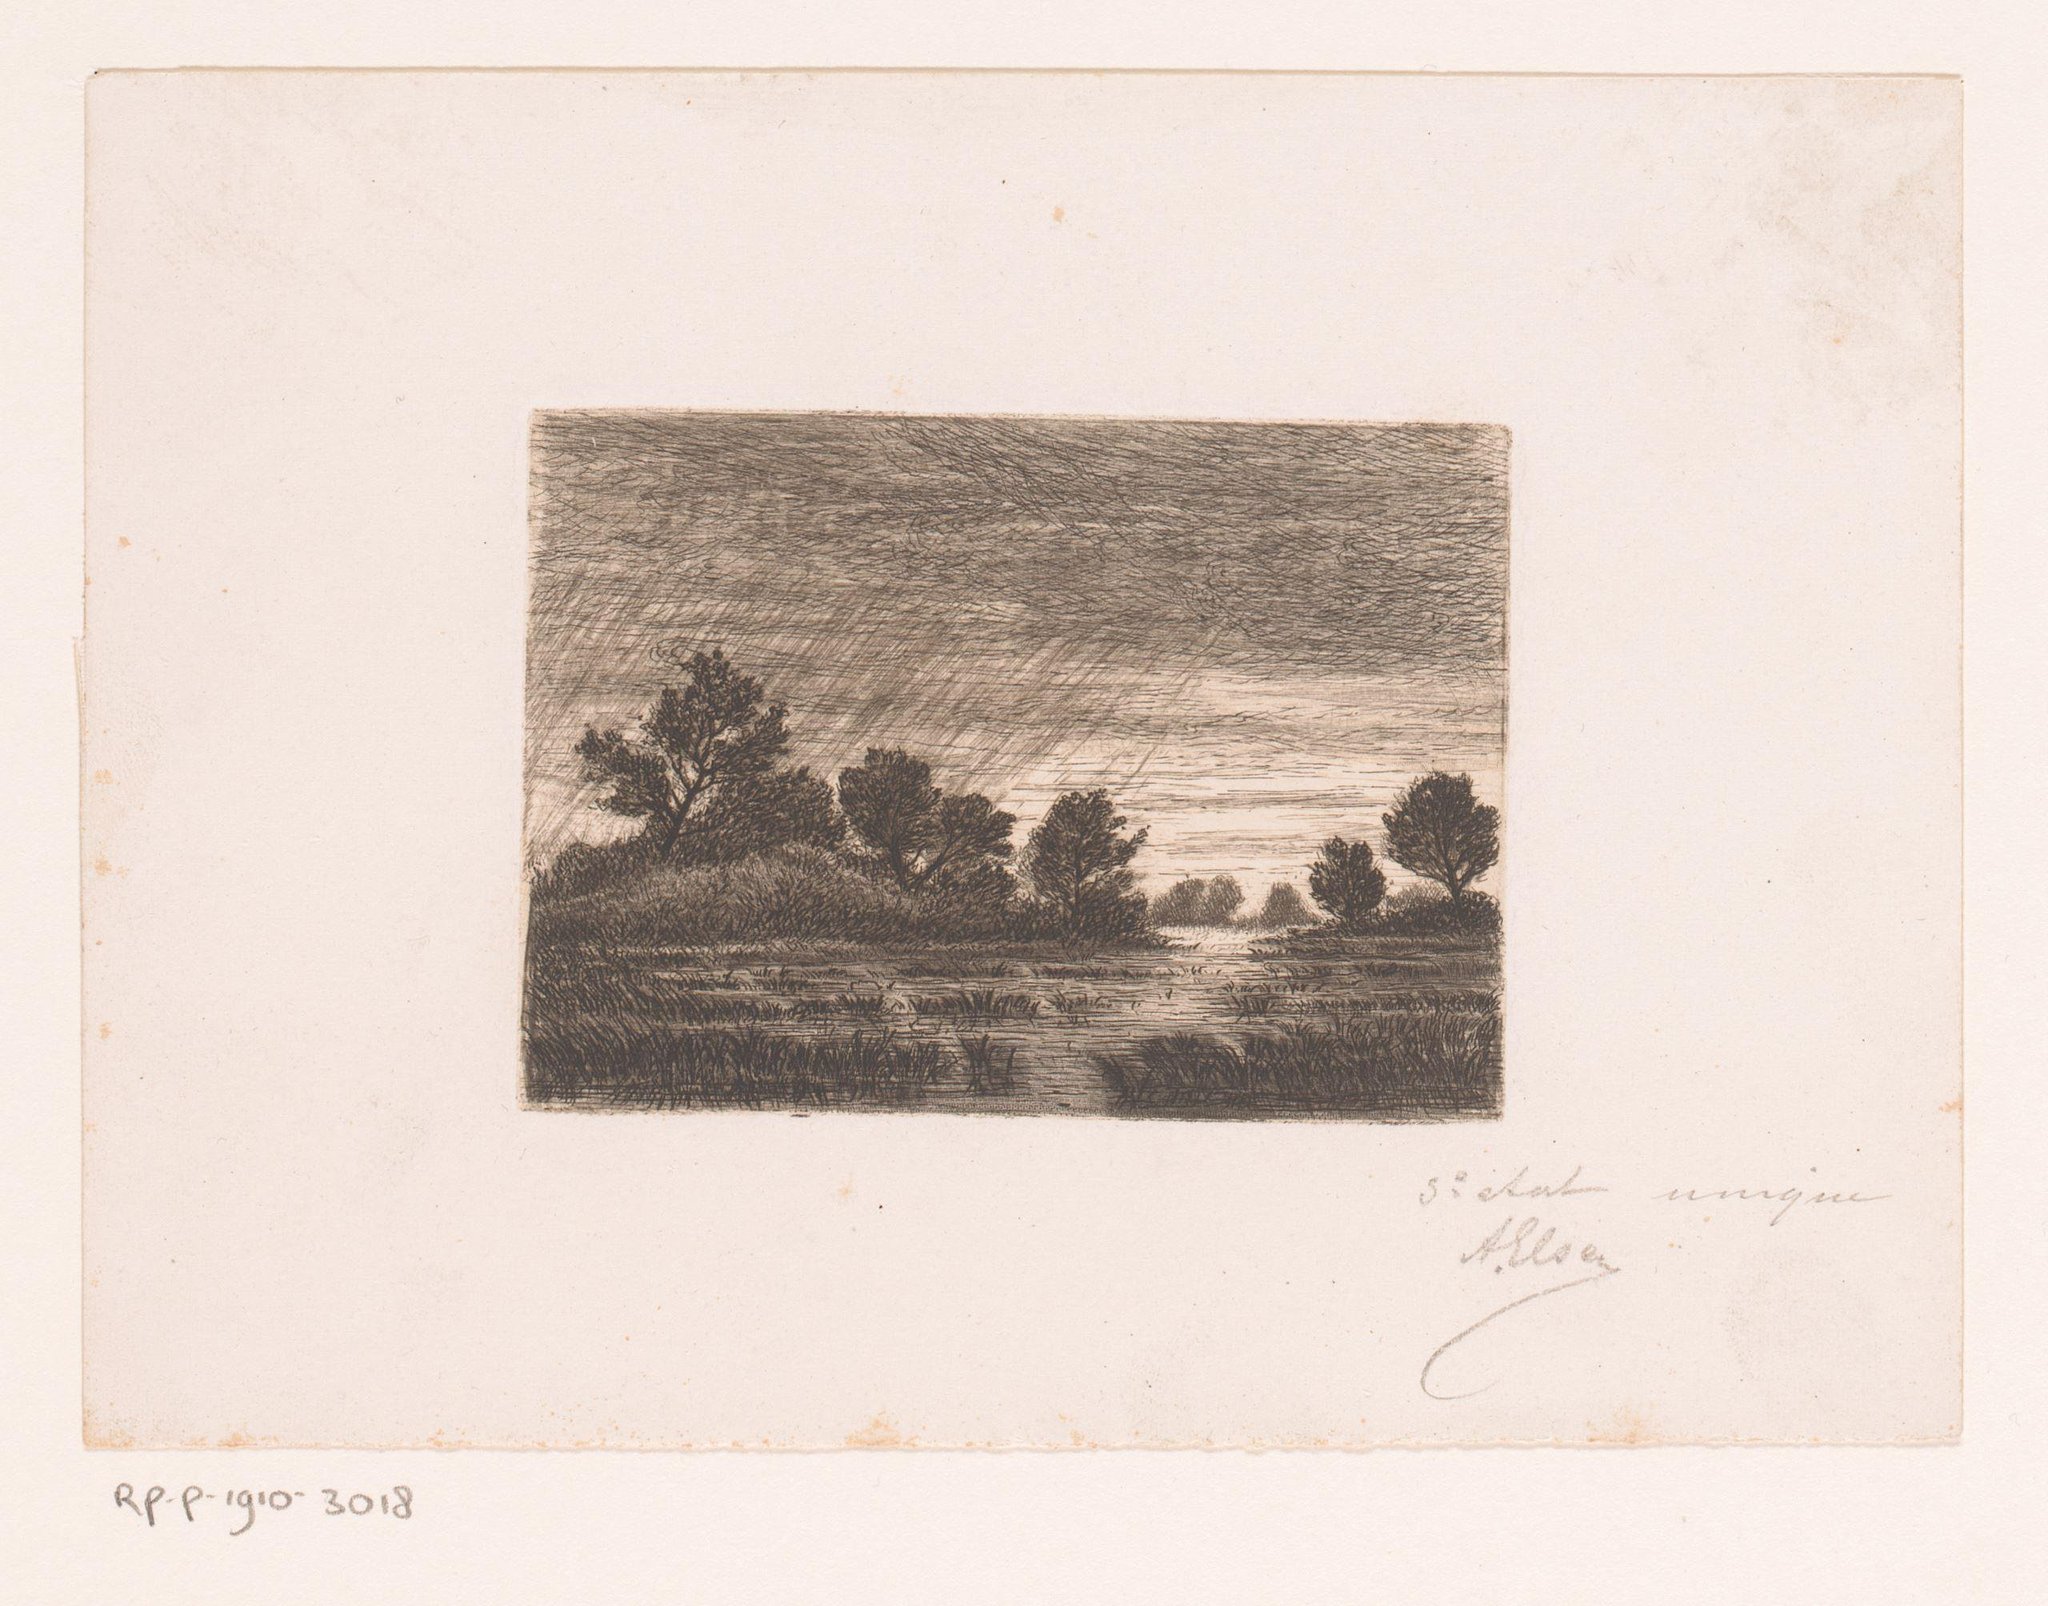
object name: print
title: Landschap met regenbui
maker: alfred elsen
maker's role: painter, print maker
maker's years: 1850-1914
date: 1860-1910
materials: paper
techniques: etching, intaglio, roulette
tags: downpour, rain shower, landscapes with waters, waterscapes, seascapes (in the temperate zone)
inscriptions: collector's mark: Lugt 2228, inscription: ‘3e etat unique’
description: Er bevinden zich vier afdrukken van deze prent in de collectie van het Rijksmuseum. Deze vier afdrukken lijken allemaal dezelfde staat, maar de opschriften in potlood geven aan dat het zou gaan om vier unieke staten.